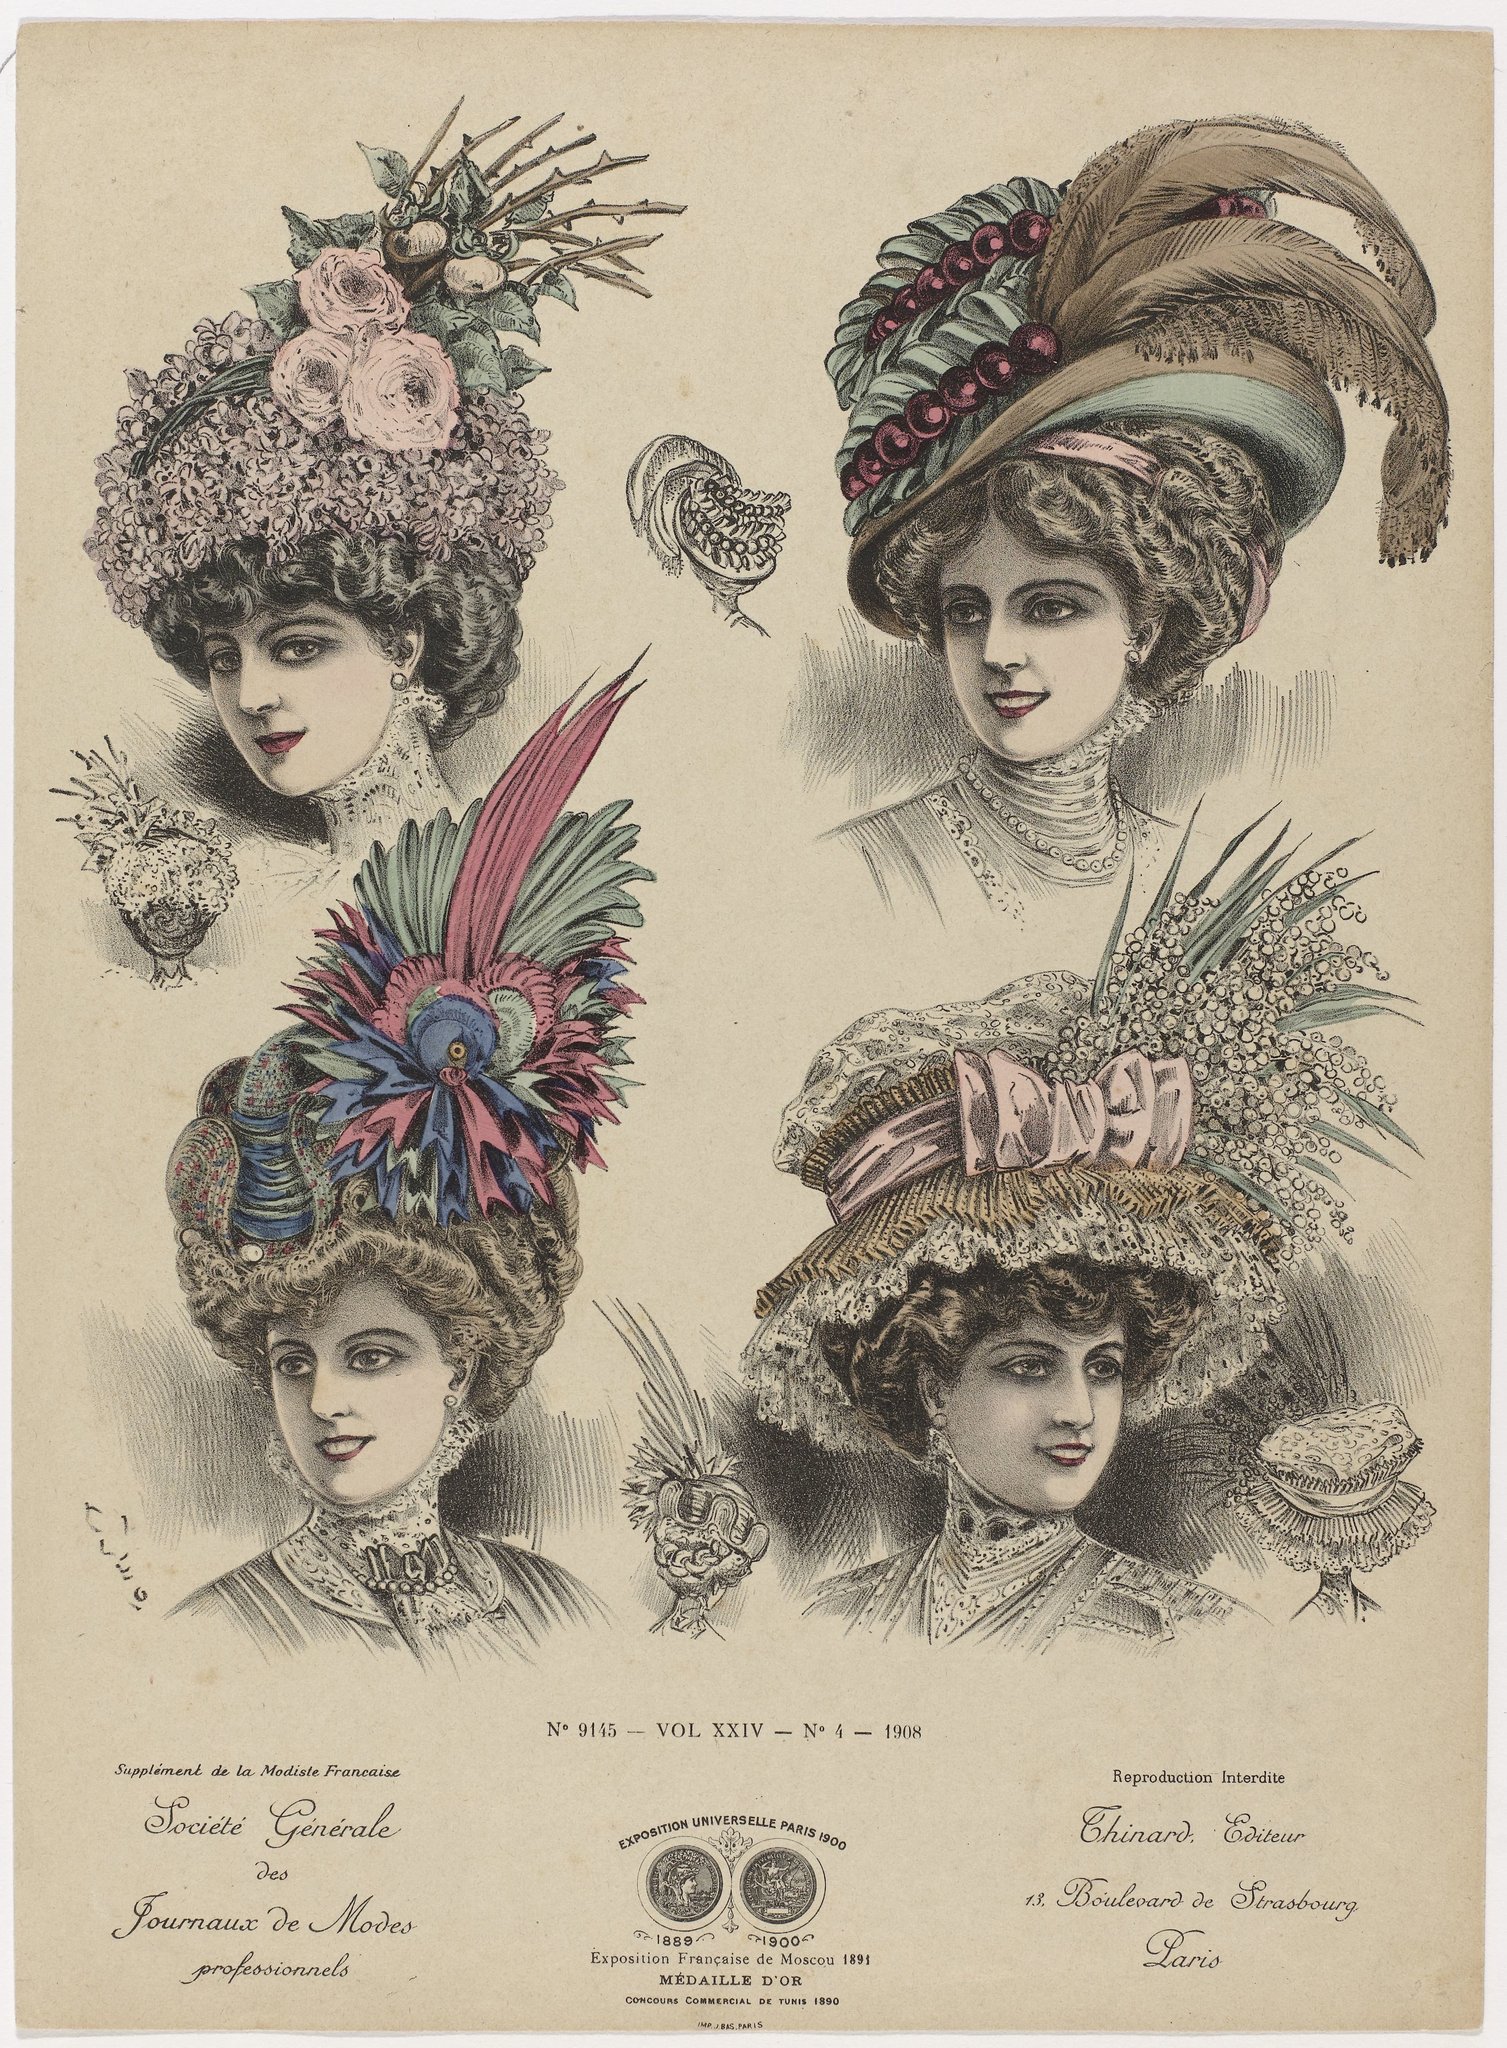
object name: fashion print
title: Supplément de la Modiste Française, Société Générale des Journaux de Modes professionnels 1908, No. 9145, Vol. XXIV, No. 4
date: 1908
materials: paper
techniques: hand coloring, lithograph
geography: paris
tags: bow (ornamental part of clothing) (+ women's clothes), flowers, fashion plates, head-gear: hat (+ women's clothes), head-gear: hat (+ feathers used for clothes)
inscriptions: inscription: ‘EXPOSITION UNIVERSELLE PARIS 1900 / 1889 - 1900 / Exposition Française de Moscou 1891 / MÉDAILLE D'OR / CONCOURS COMMERCIAL DE TUNIS 1890’, title: ‘Supplément de la Modiste Francaise / Société Générale des Journaux de Modes professionels’, address: ‘Reproduction Interdite / Thinard Editeur 13, Boulevard de Strasbourg Paris’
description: Vier vrouwenhoofden met diverse hoeden en mutsen, versierd met rozen, bloemen, veren, vogelkopje en lint. Naast iedere hoed een kleine lijntekening van de achterkant. Prent uit het modetijdschrift 'La Modiste Française' (1885-1914).